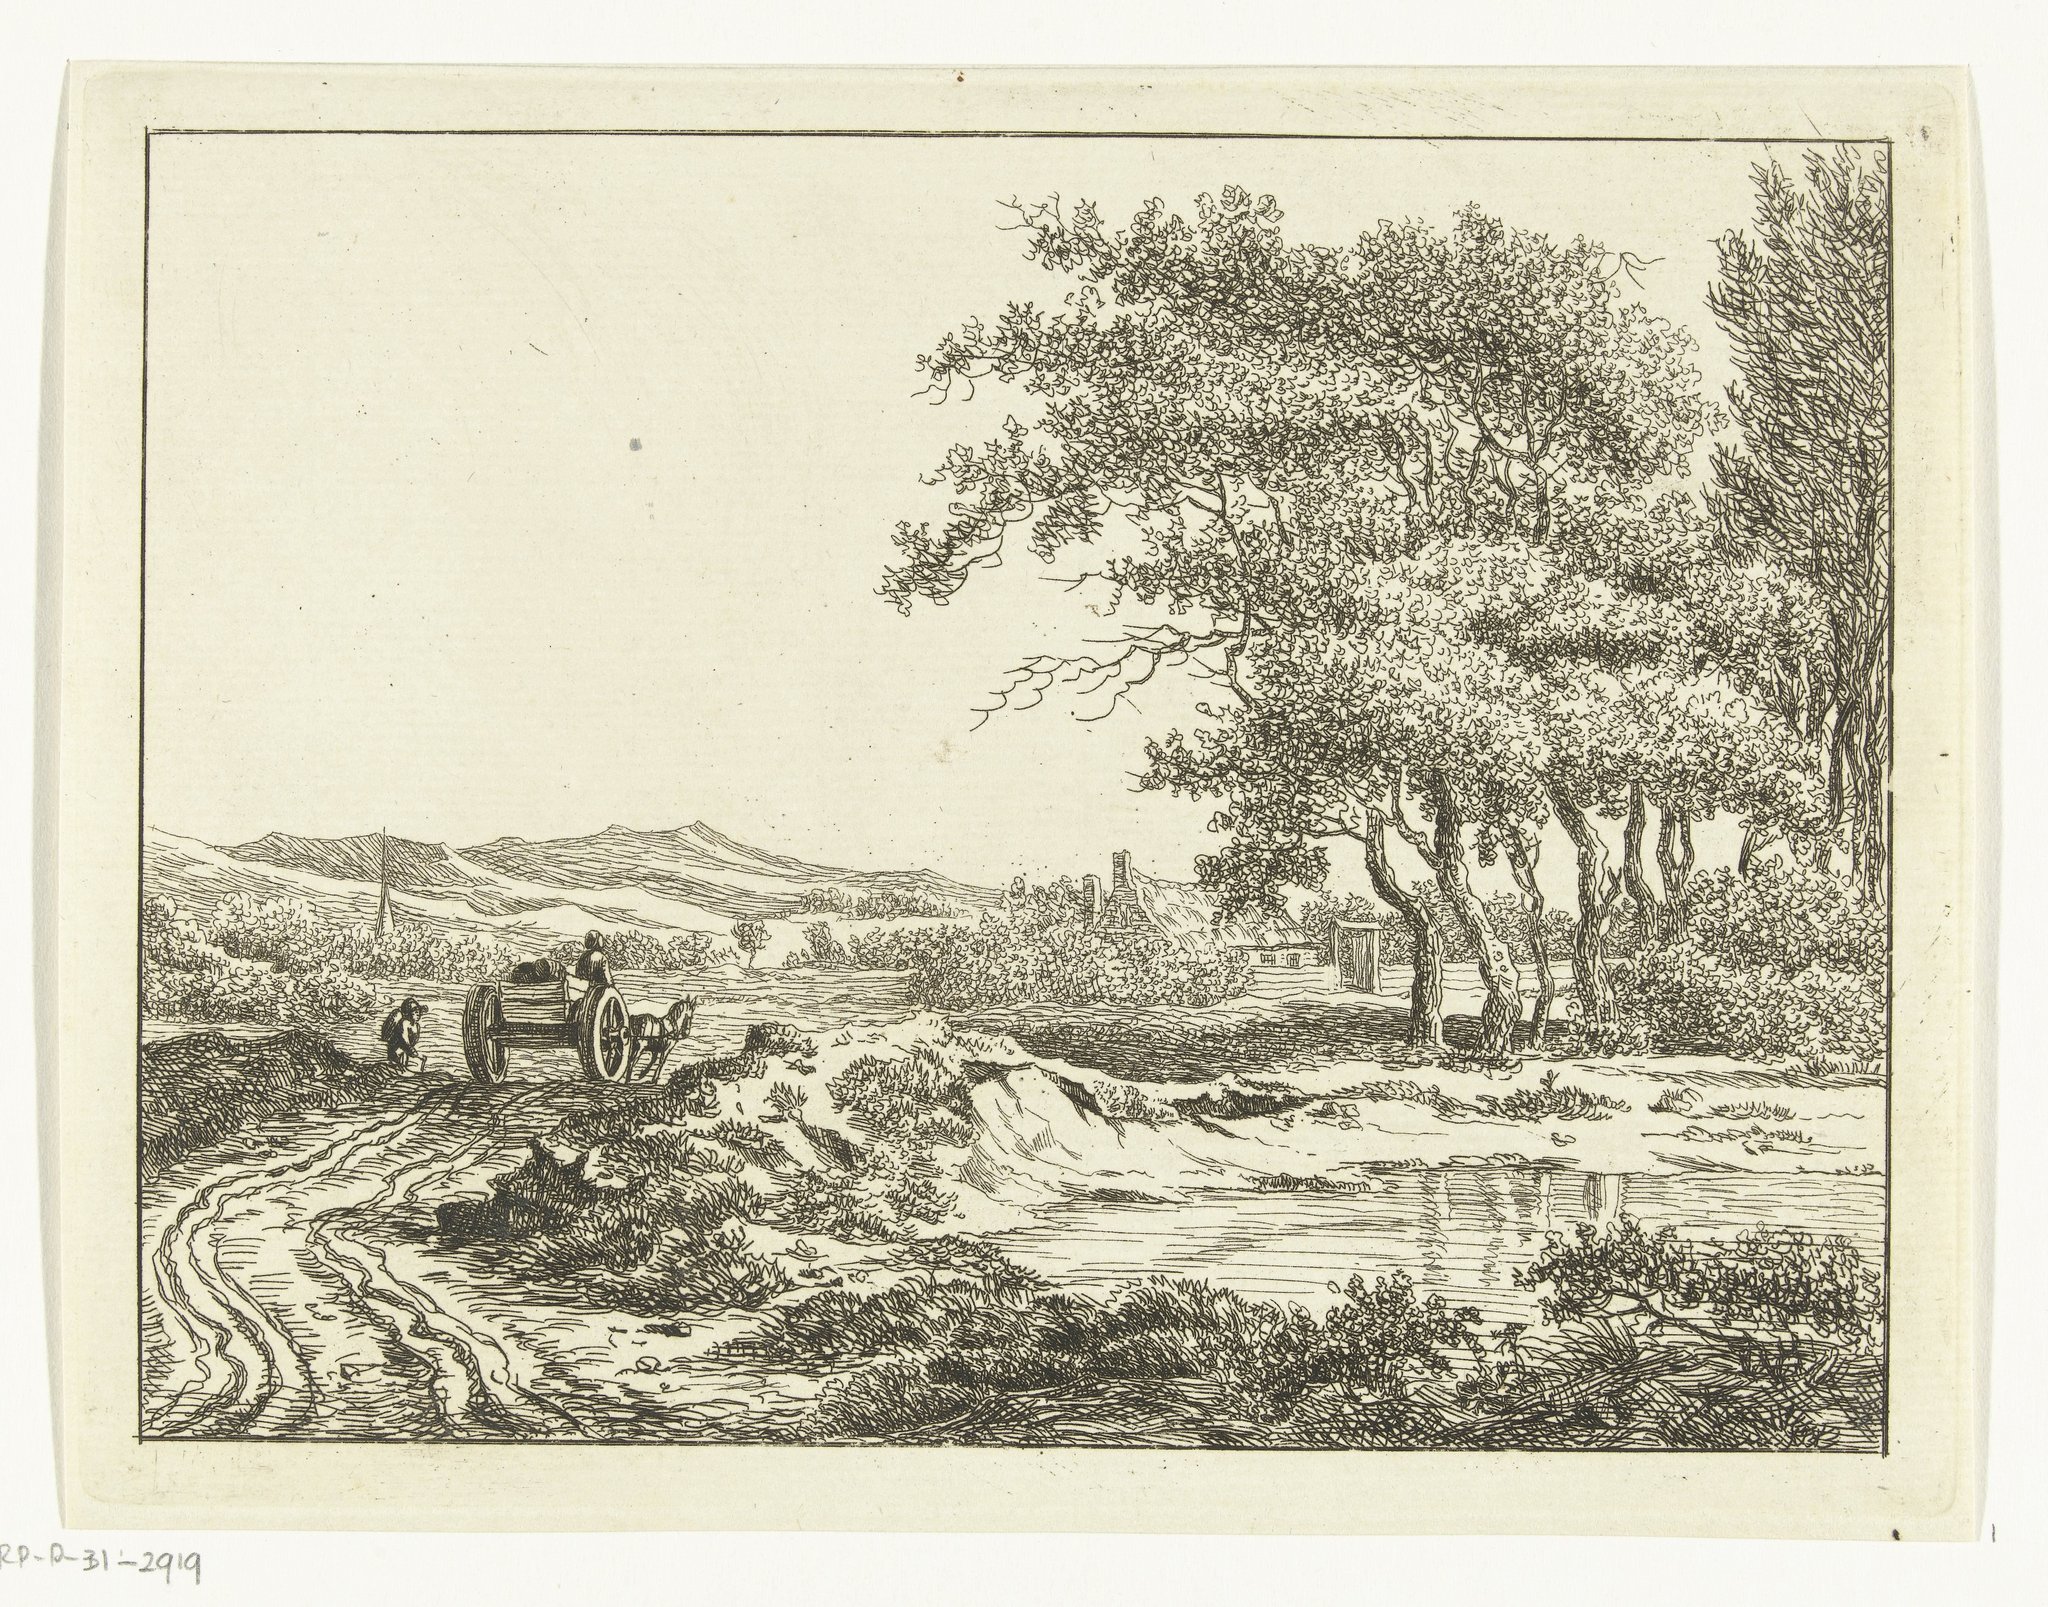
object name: print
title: Kar op een landweg bij de duinen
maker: anthonie van den bos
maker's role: draughtsman, print maker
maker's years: 1763-1838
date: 1778-1838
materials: paper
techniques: etching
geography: netherlands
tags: ruin of a dwelling, house, castle, etc.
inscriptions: collector's mark: Lugt 2228